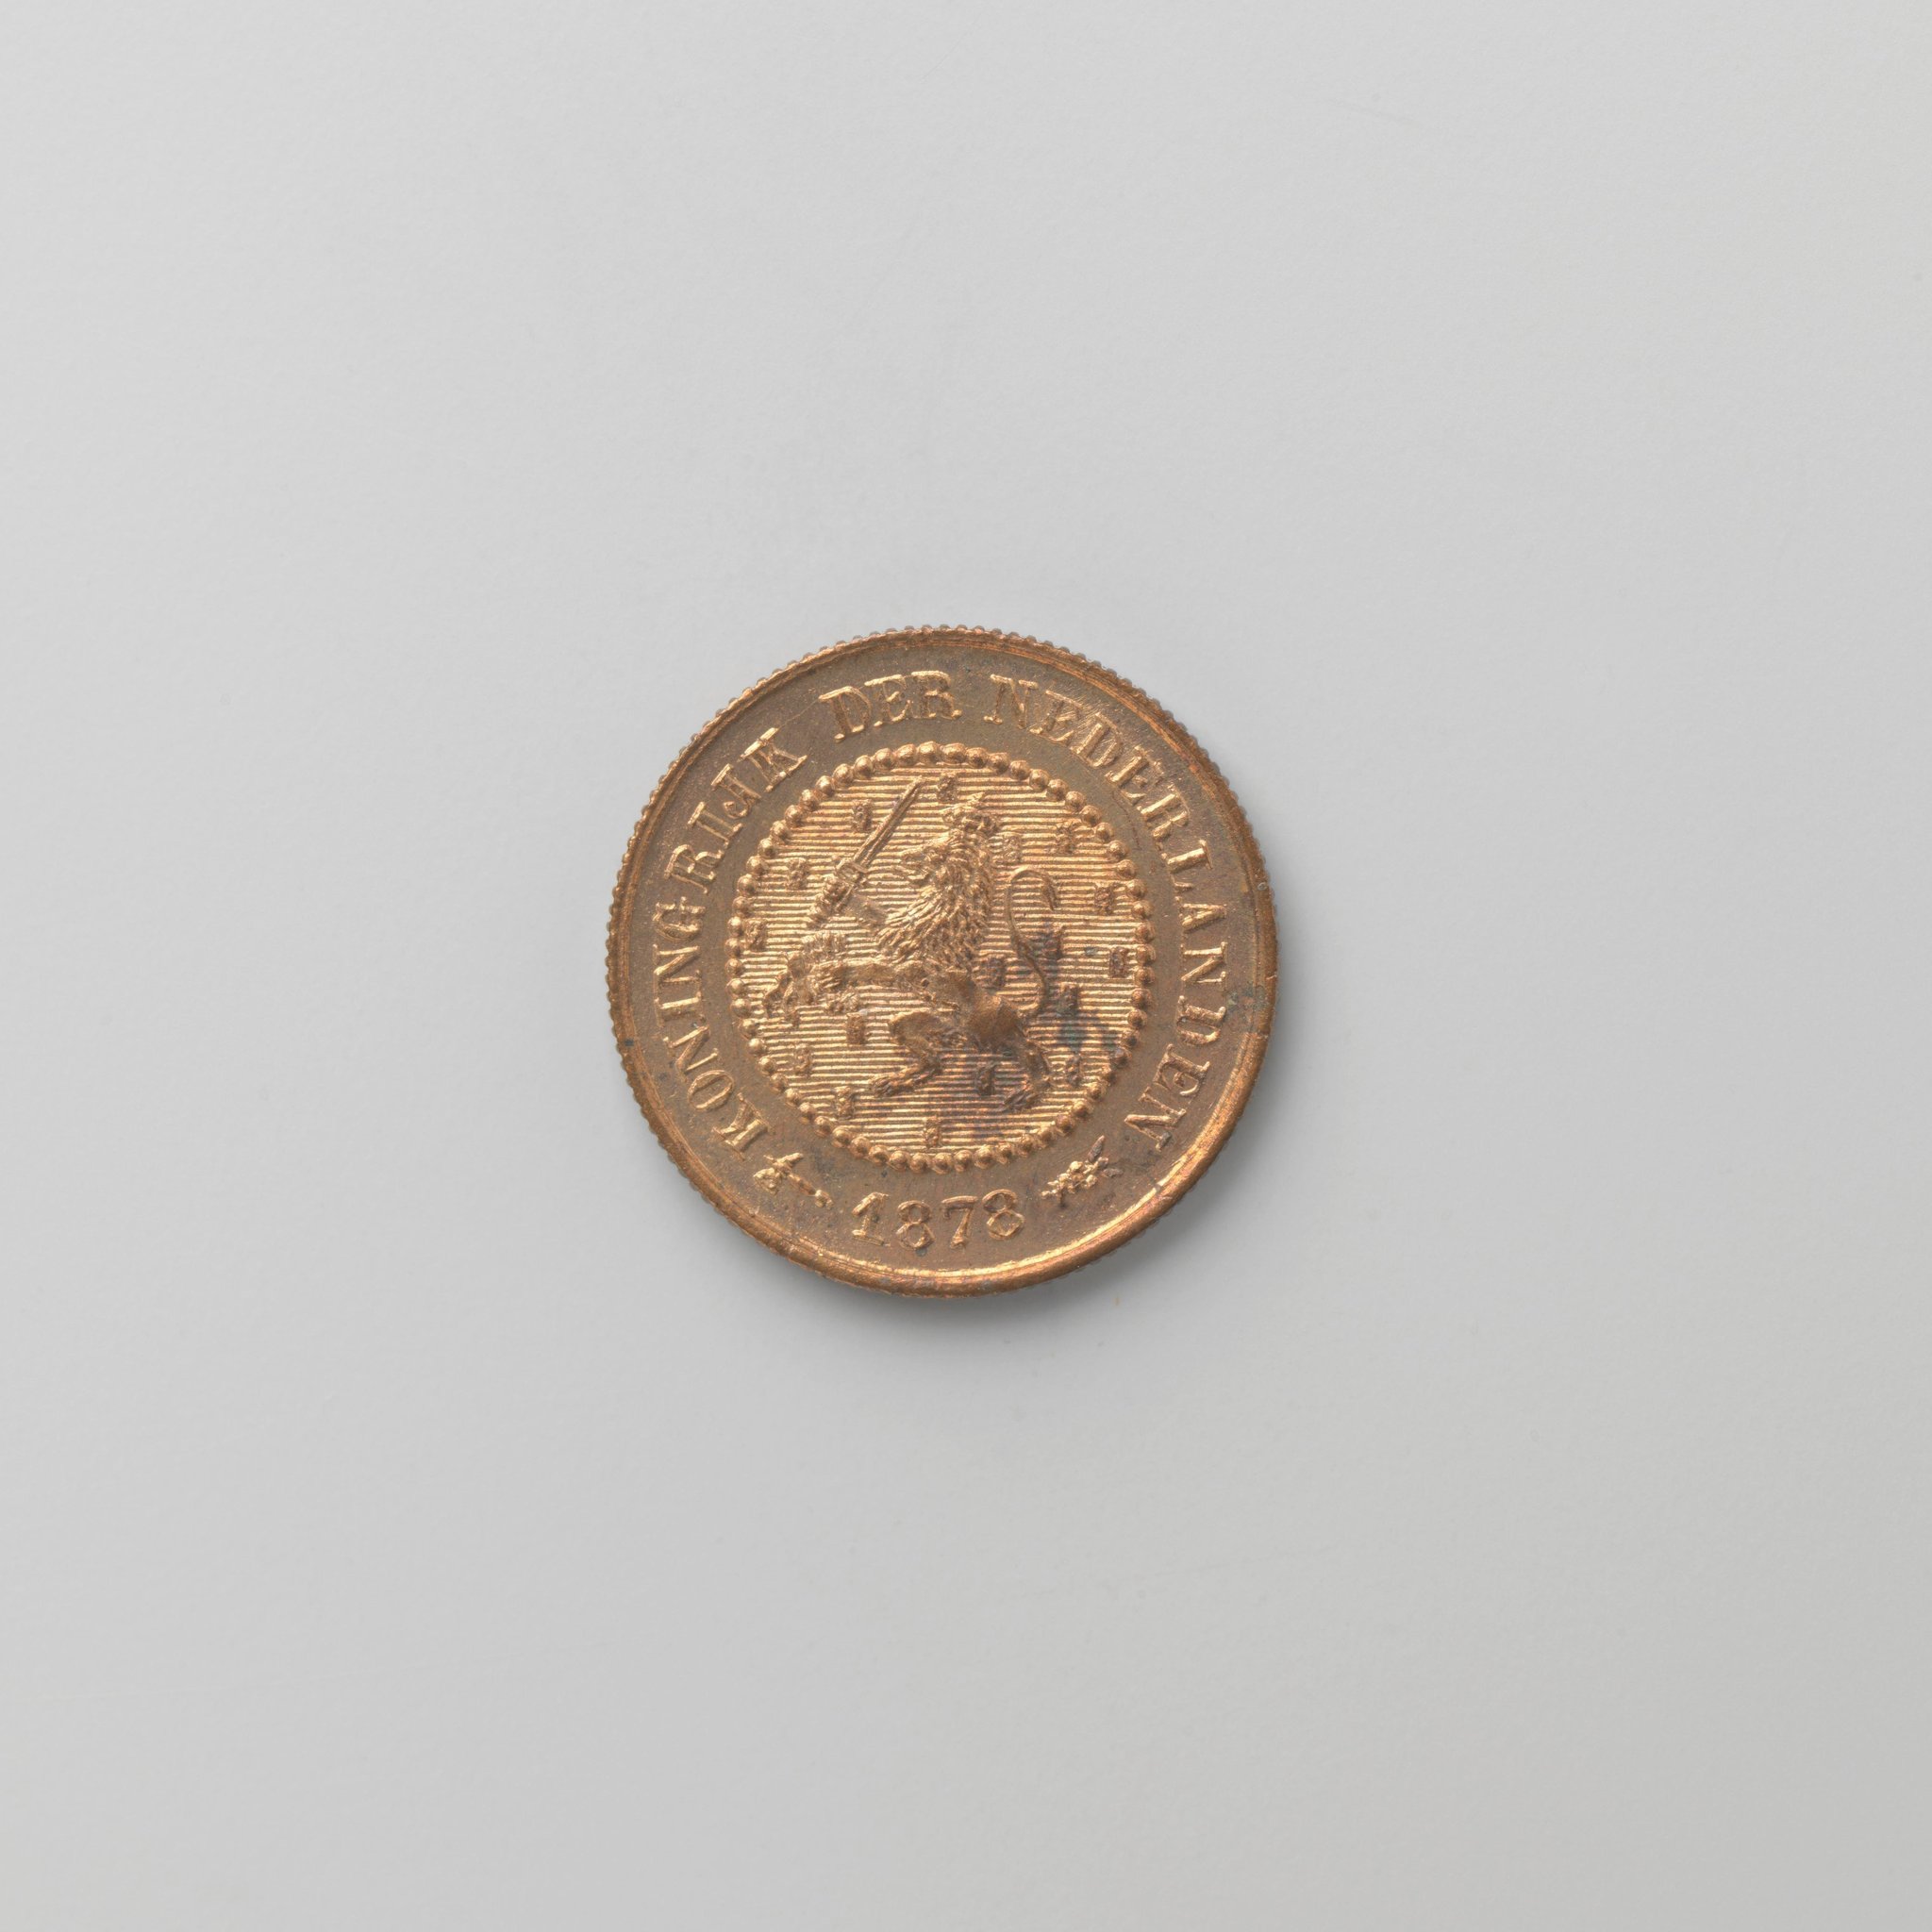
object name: coin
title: Nederland, ½ cent, 1878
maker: willem iii (koning der nederlanden)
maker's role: koning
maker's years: 1817-1890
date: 1878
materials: bronze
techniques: striking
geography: utrecht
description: Bronzen munt. Voorzijde: in een veld rijkswapen. Jaartal onderaan in omschrift. Keerzijde: binnen twee samengebonden oranjetakken waarde-aanduiding ½ cent. Kartelrand.